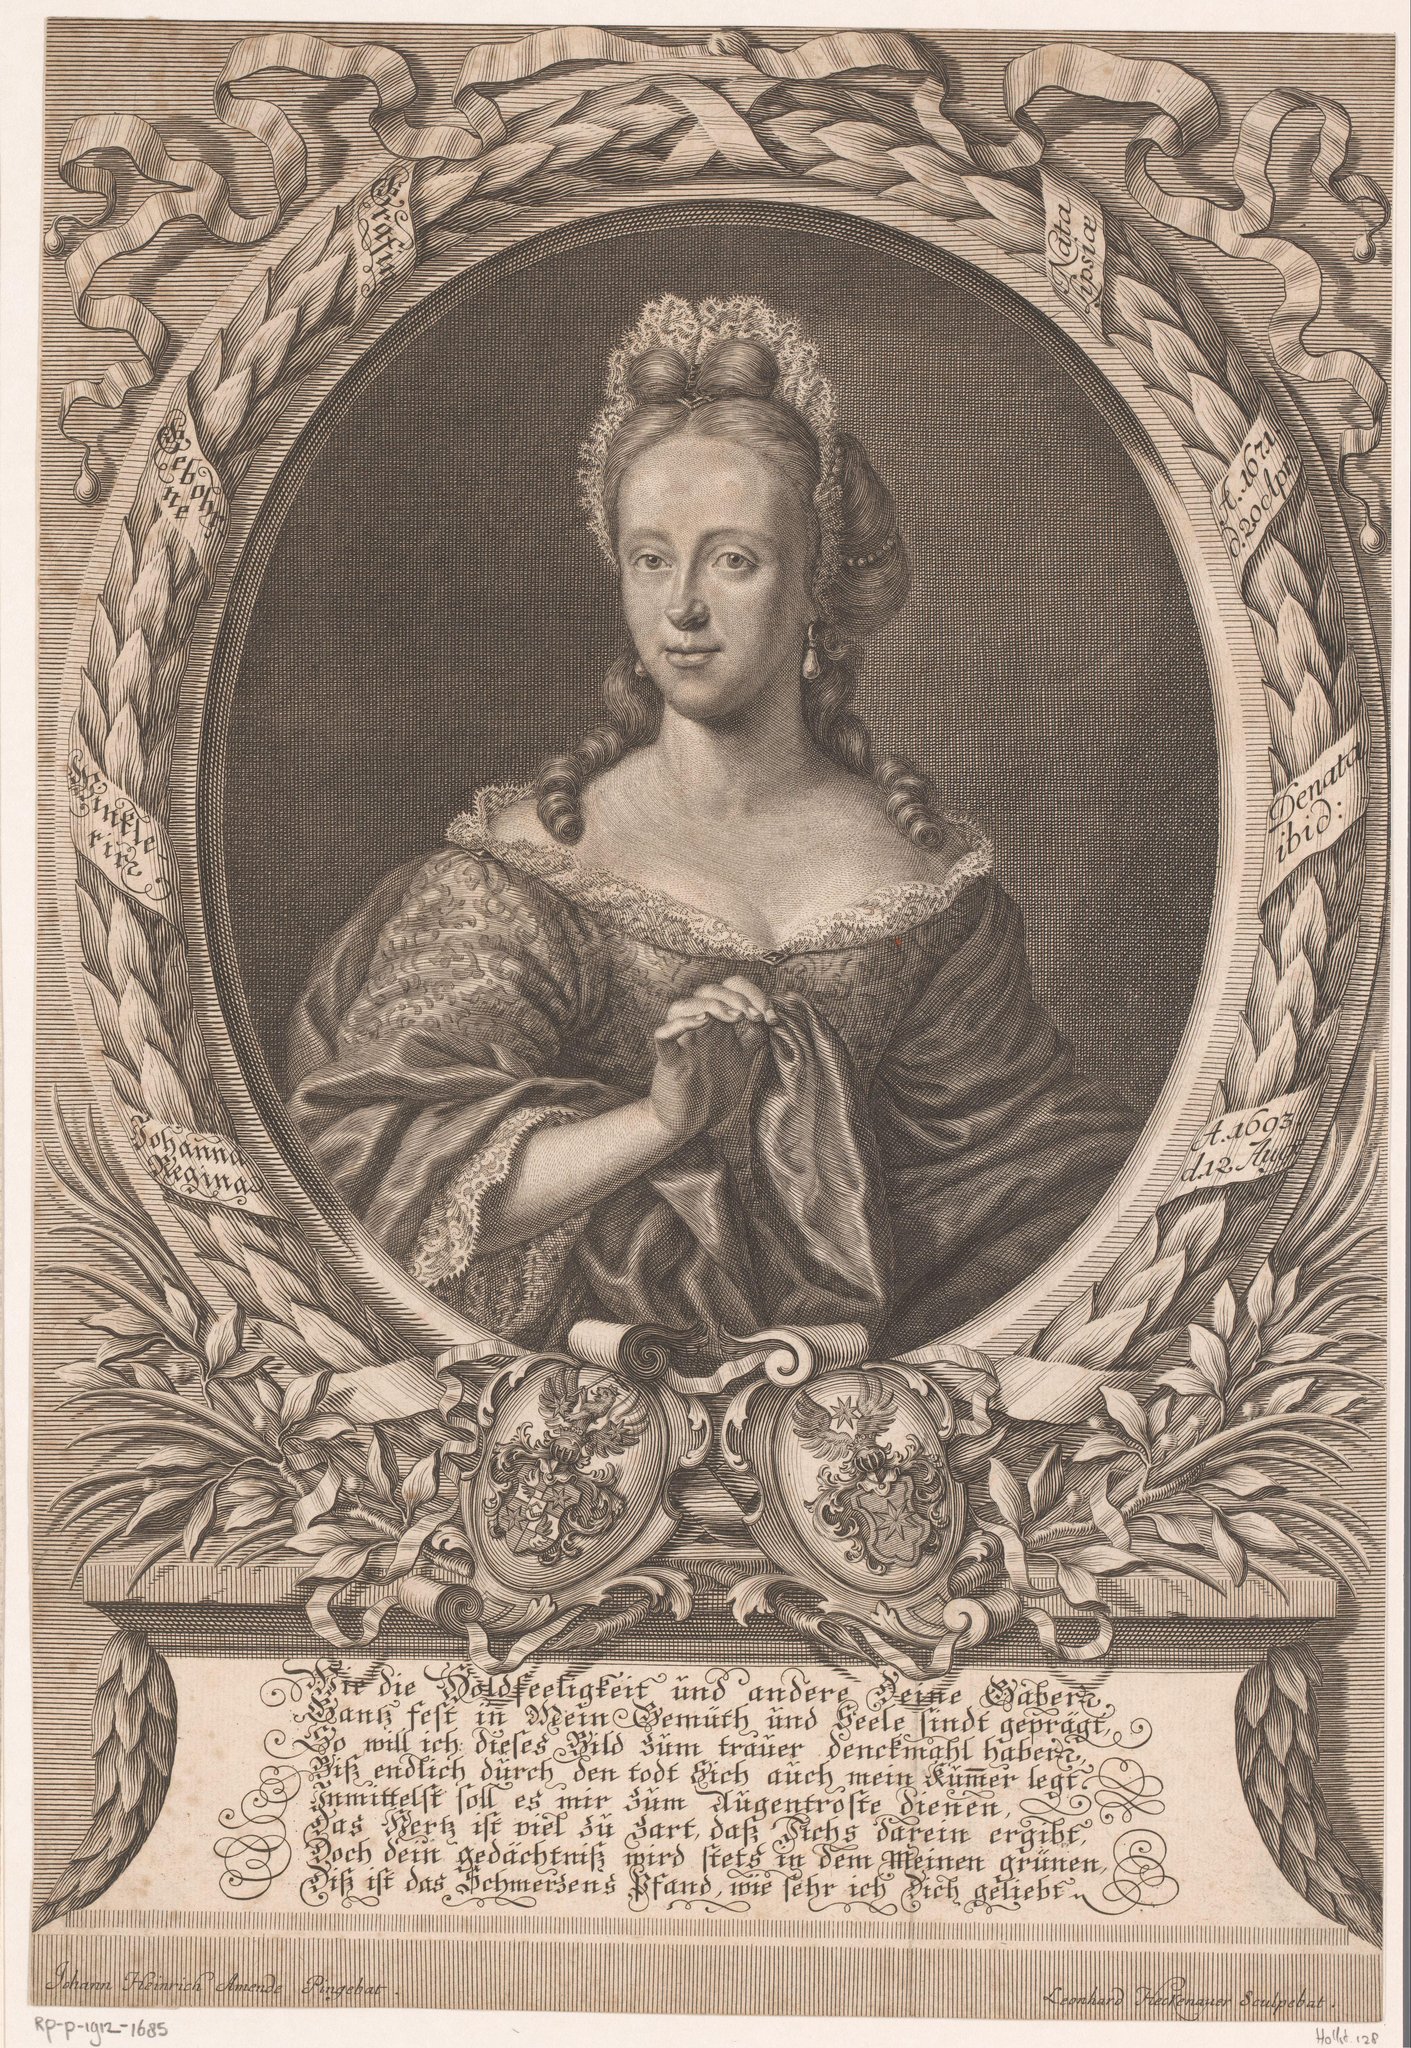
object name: print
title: Portret van Johanna Regina Winckler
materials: paper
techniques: engraving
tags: trees: laurel (branch, stick), historical persons - bb - woman, armorial bearing, heraldry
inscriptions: collector's mark: Lugt 2228